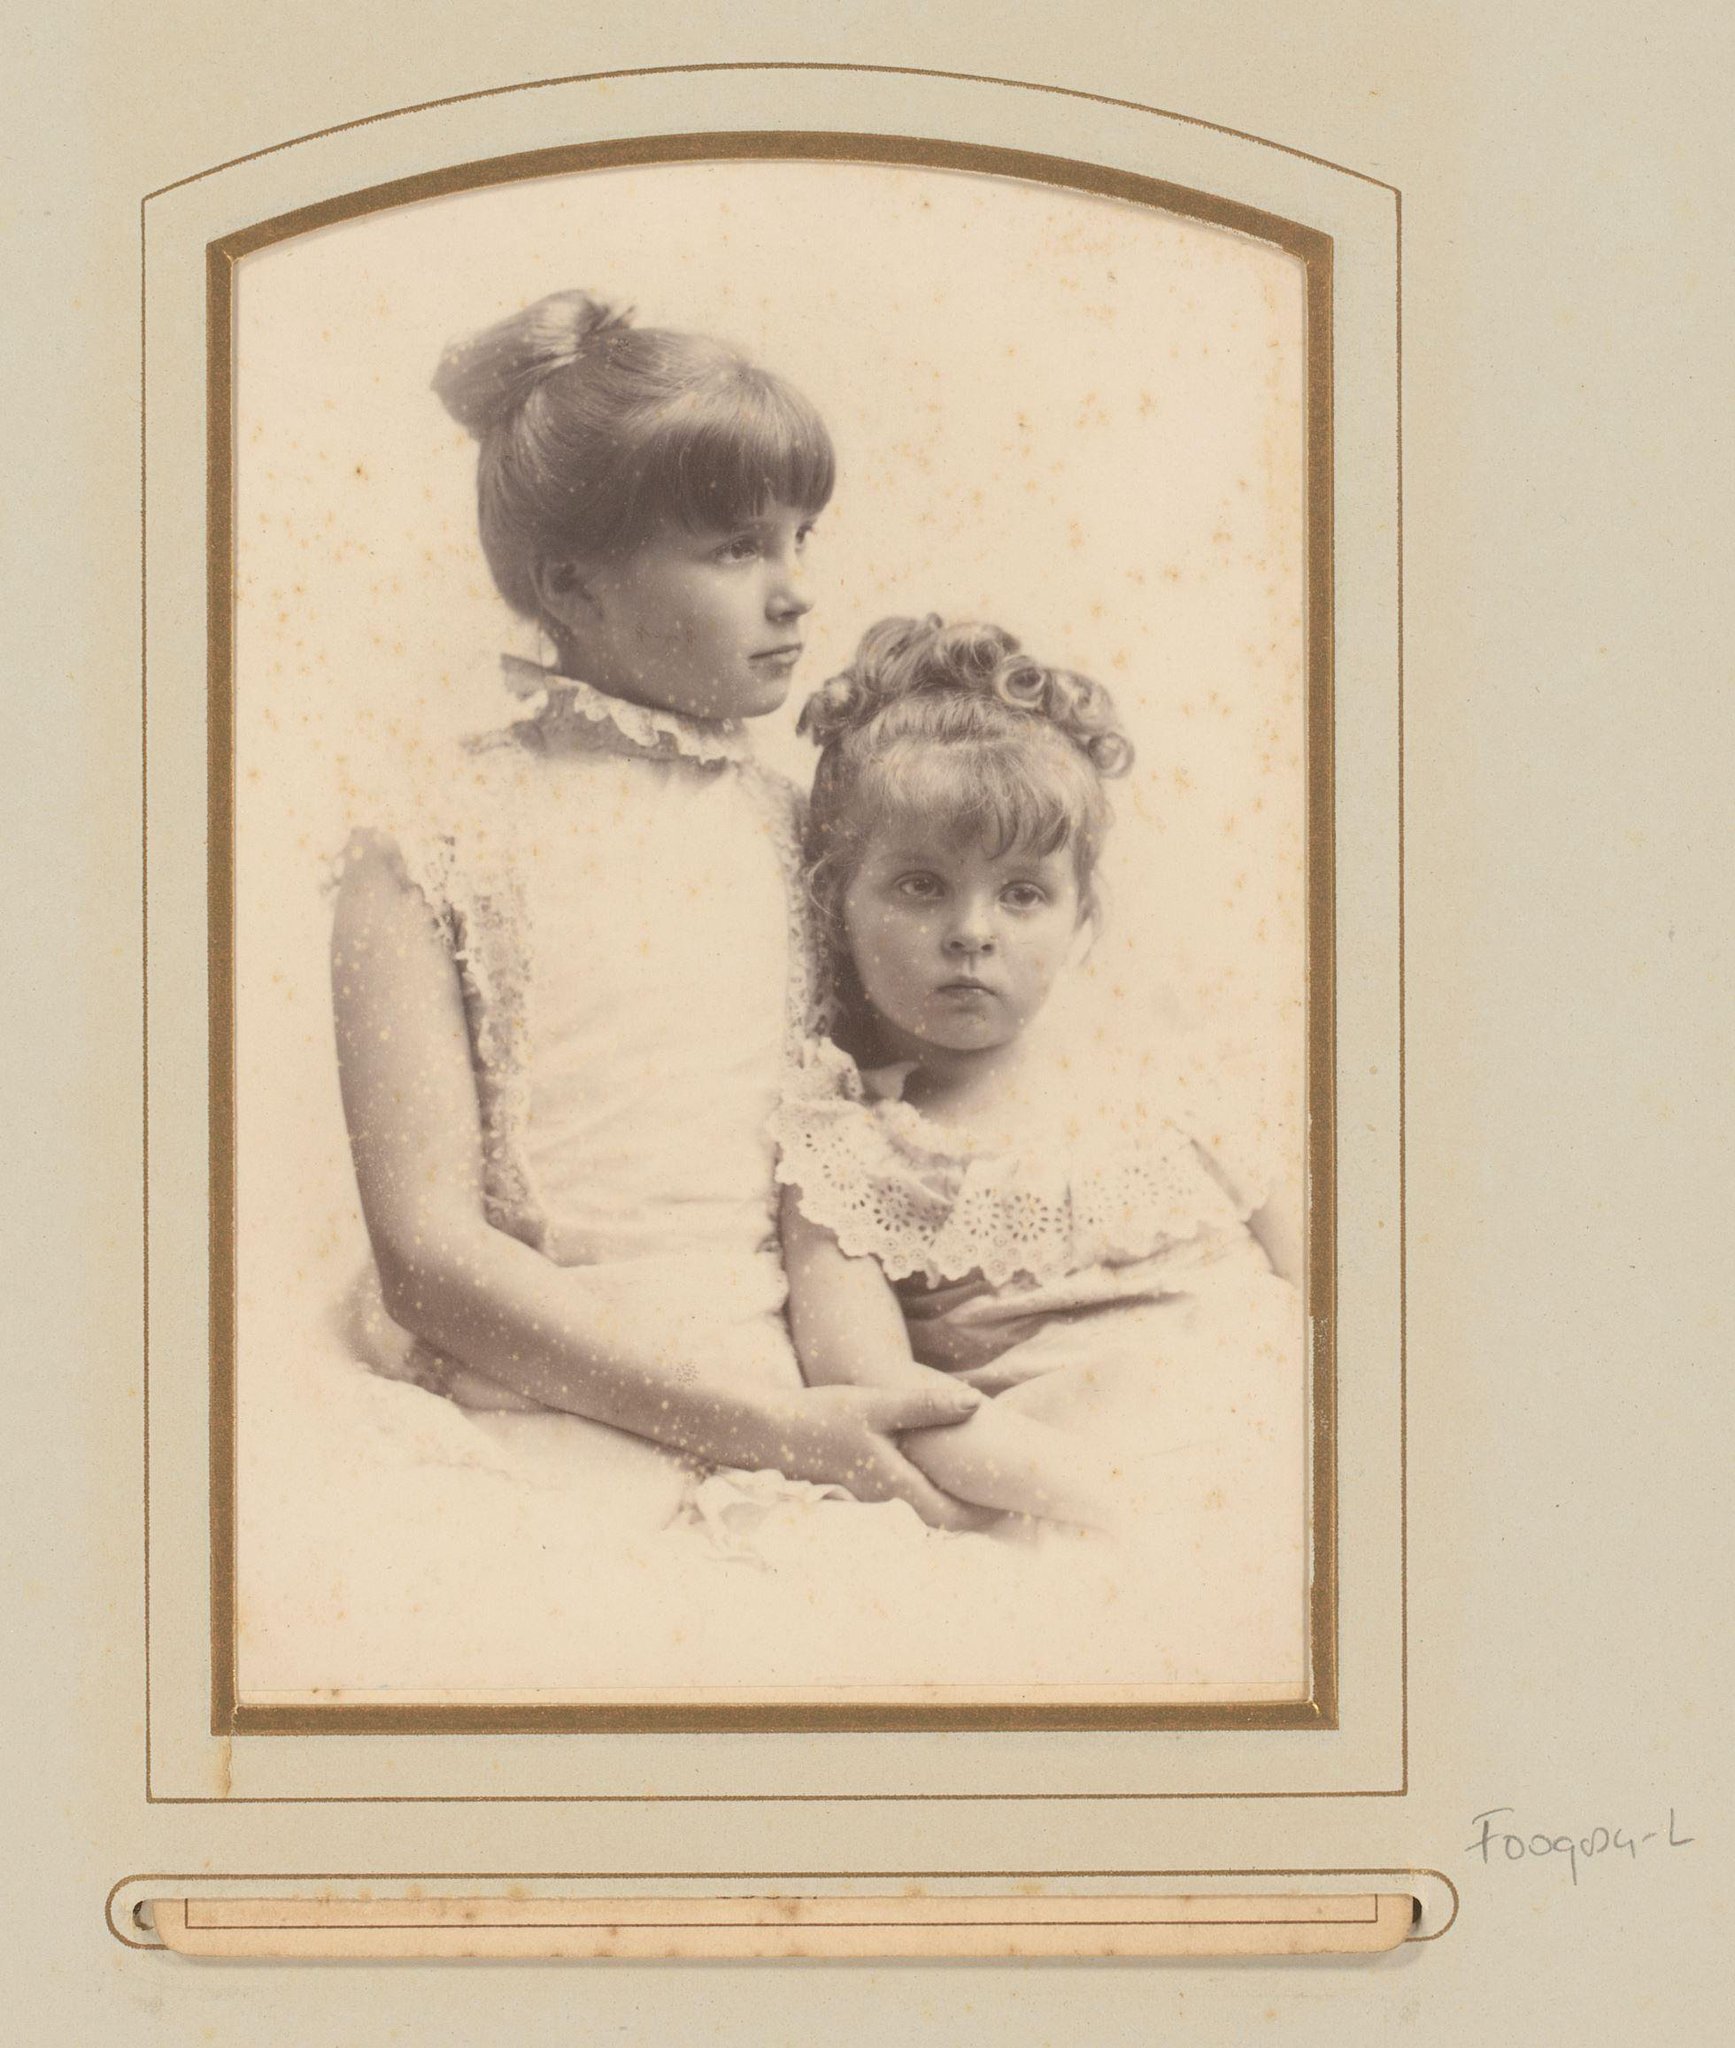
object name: album leaf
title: Portret van twee meisjes in wit kanten jurken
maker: e. vogelsang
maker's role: fotograaf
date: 1884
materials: cardboard, photographic support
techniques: albumen print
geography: berlin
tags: historical persons - bb - woman, girl (child between toddler and youth) (+ two persons)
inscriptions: number: ‘160’, inscription: ‘Phot. u. Verlag/ E. VOGELSANG./ 1884./ BERLIN/ Leipzigerstr. 114.’